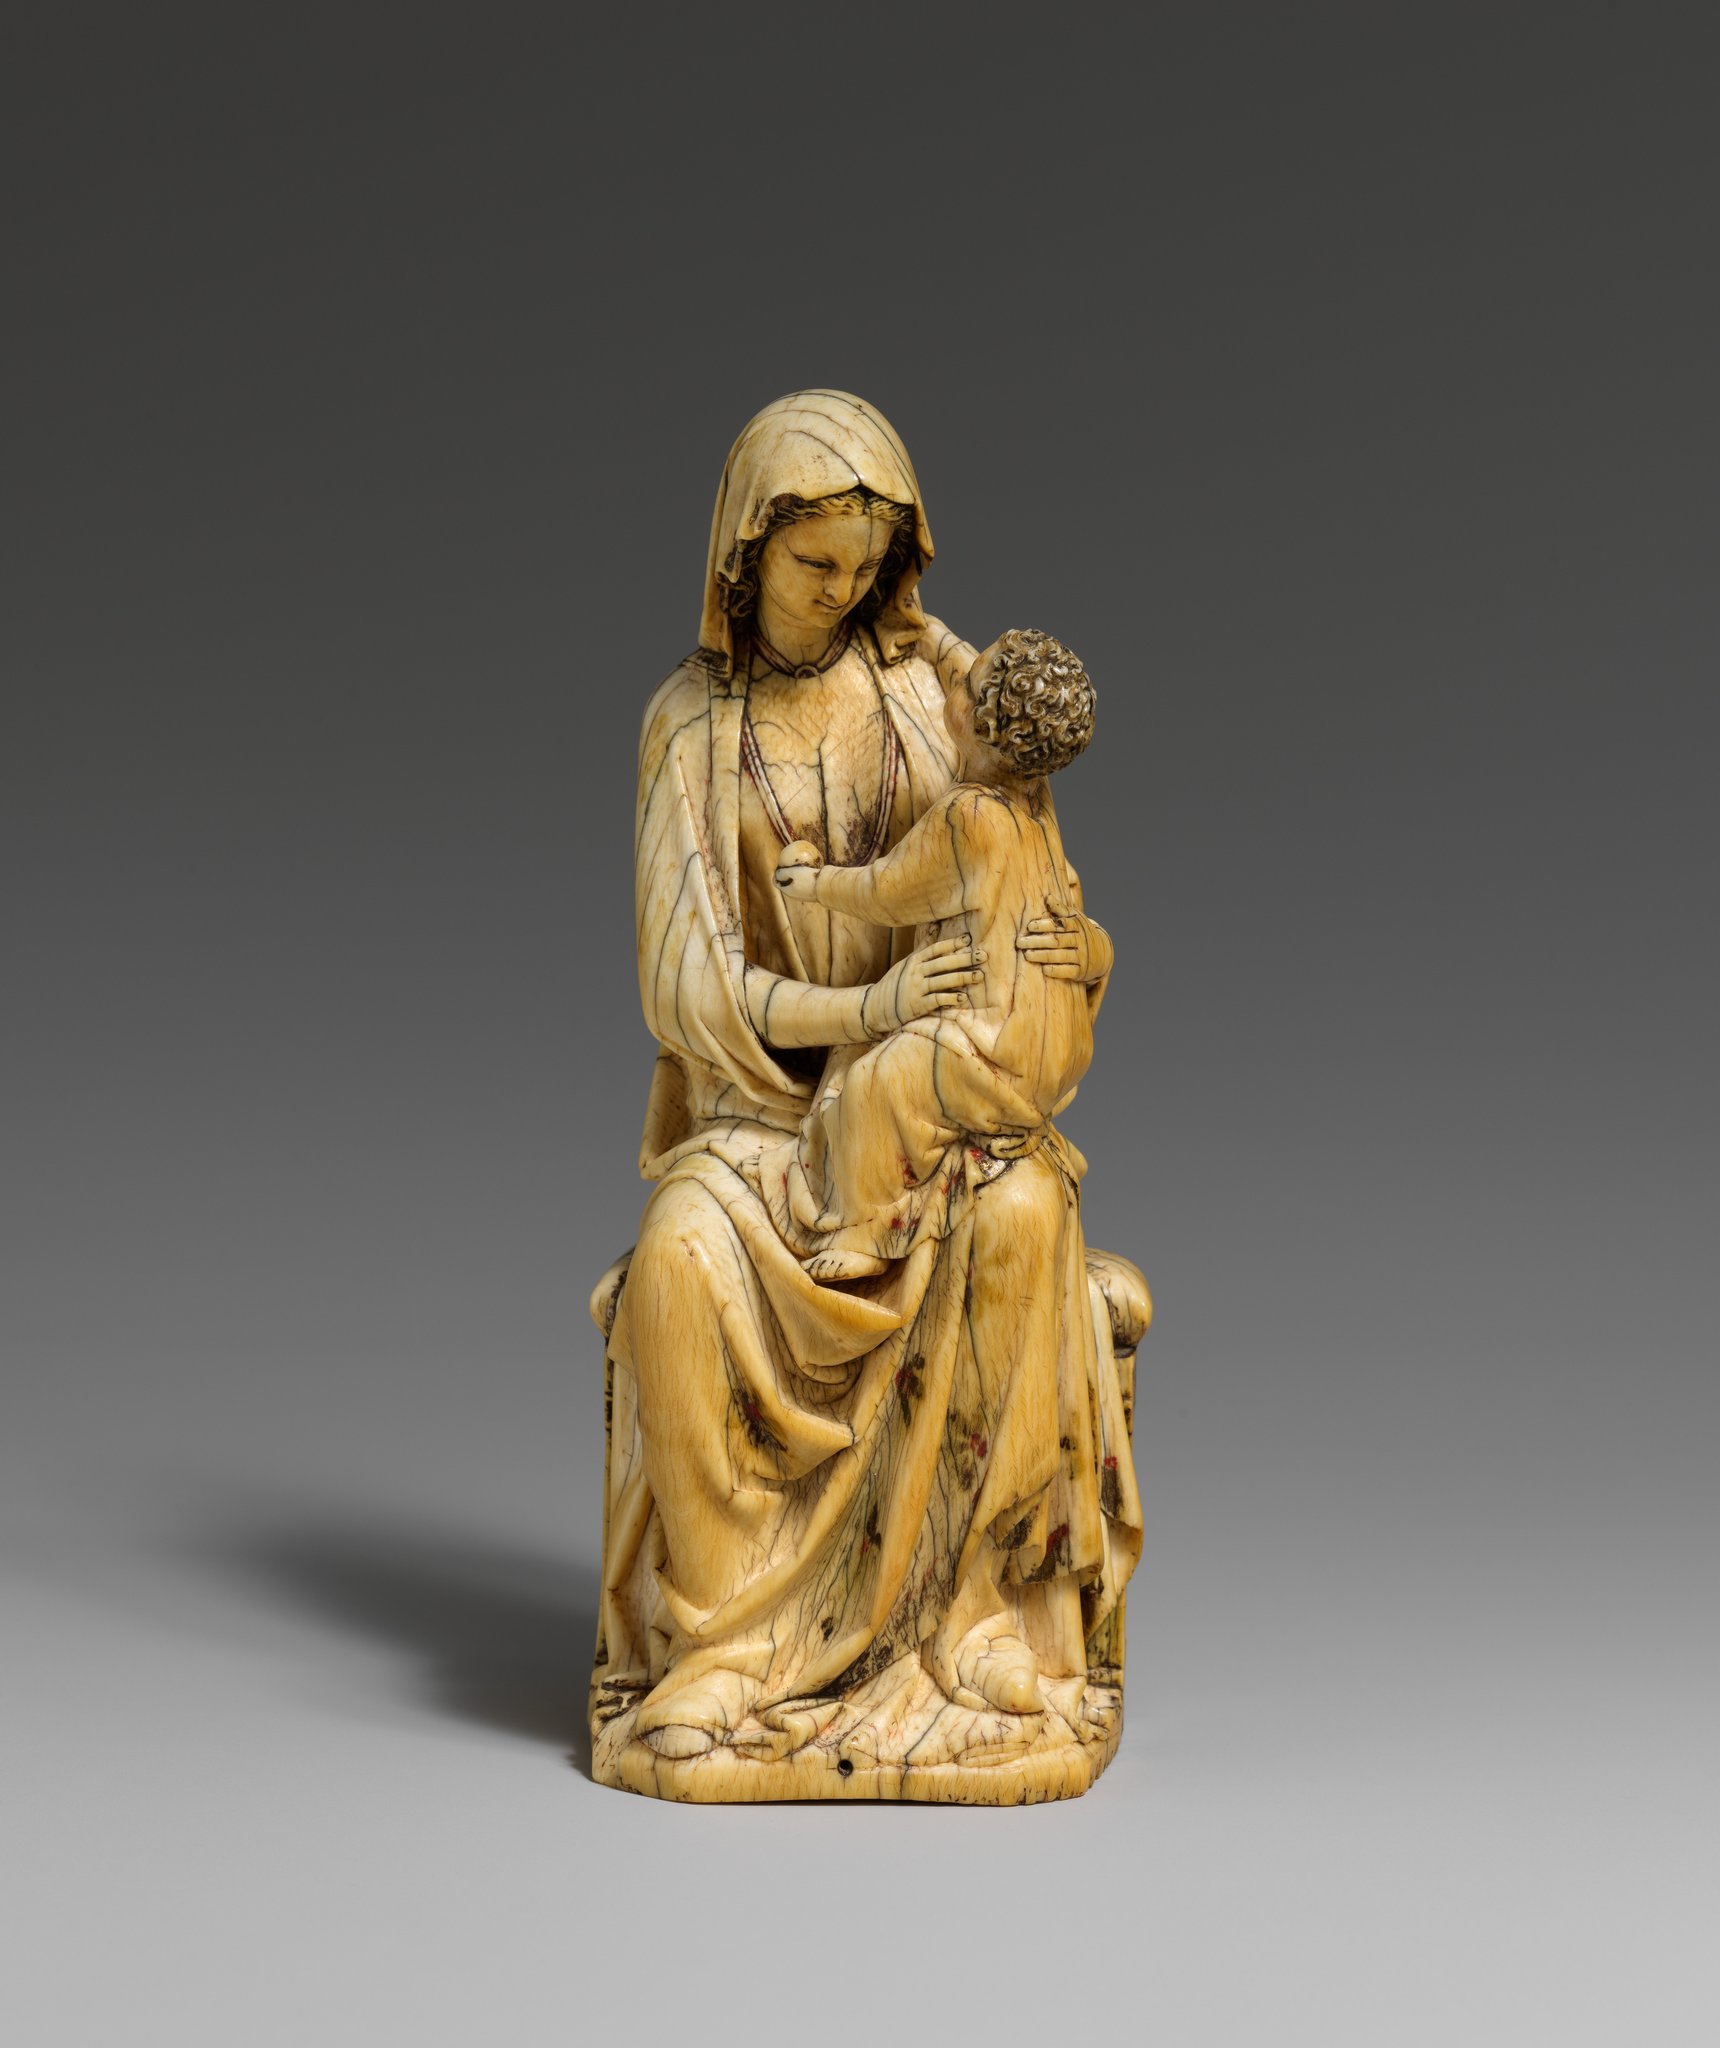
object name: statuette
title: Enthroned Virgin and Child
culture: french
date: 1260-1280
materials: ivory, paint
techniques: gilding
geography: france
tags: madonna and child